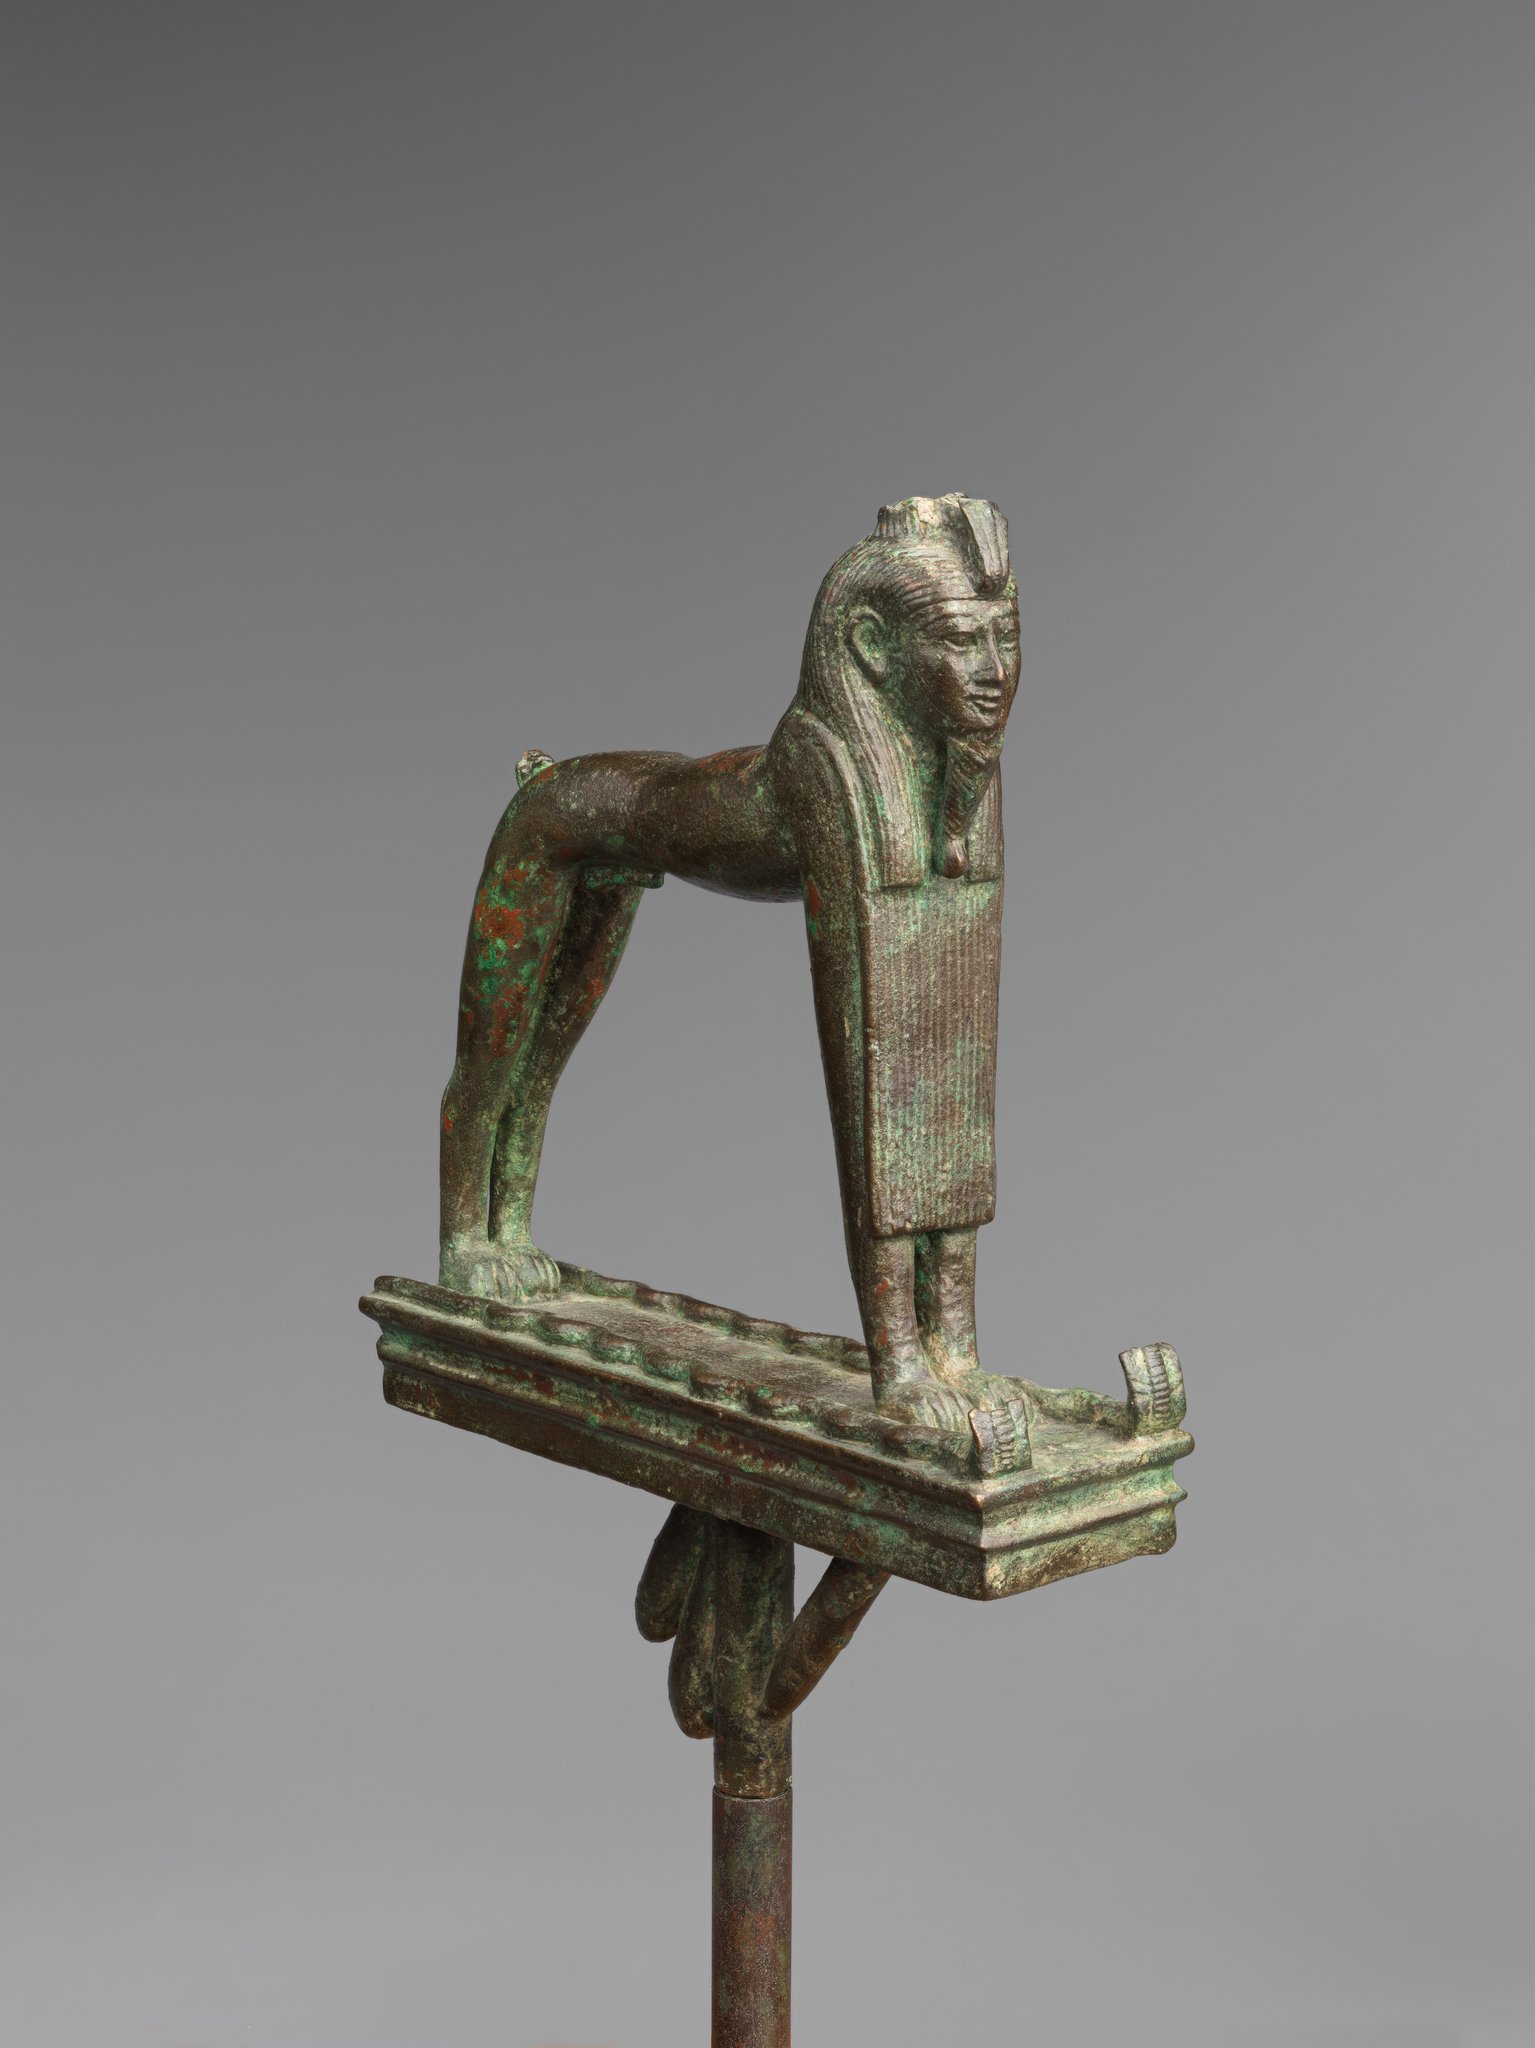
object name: barque sphinx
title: Sib sphinx for a barque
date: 664-525 BCE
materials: bronze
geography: egypt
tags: sphinx